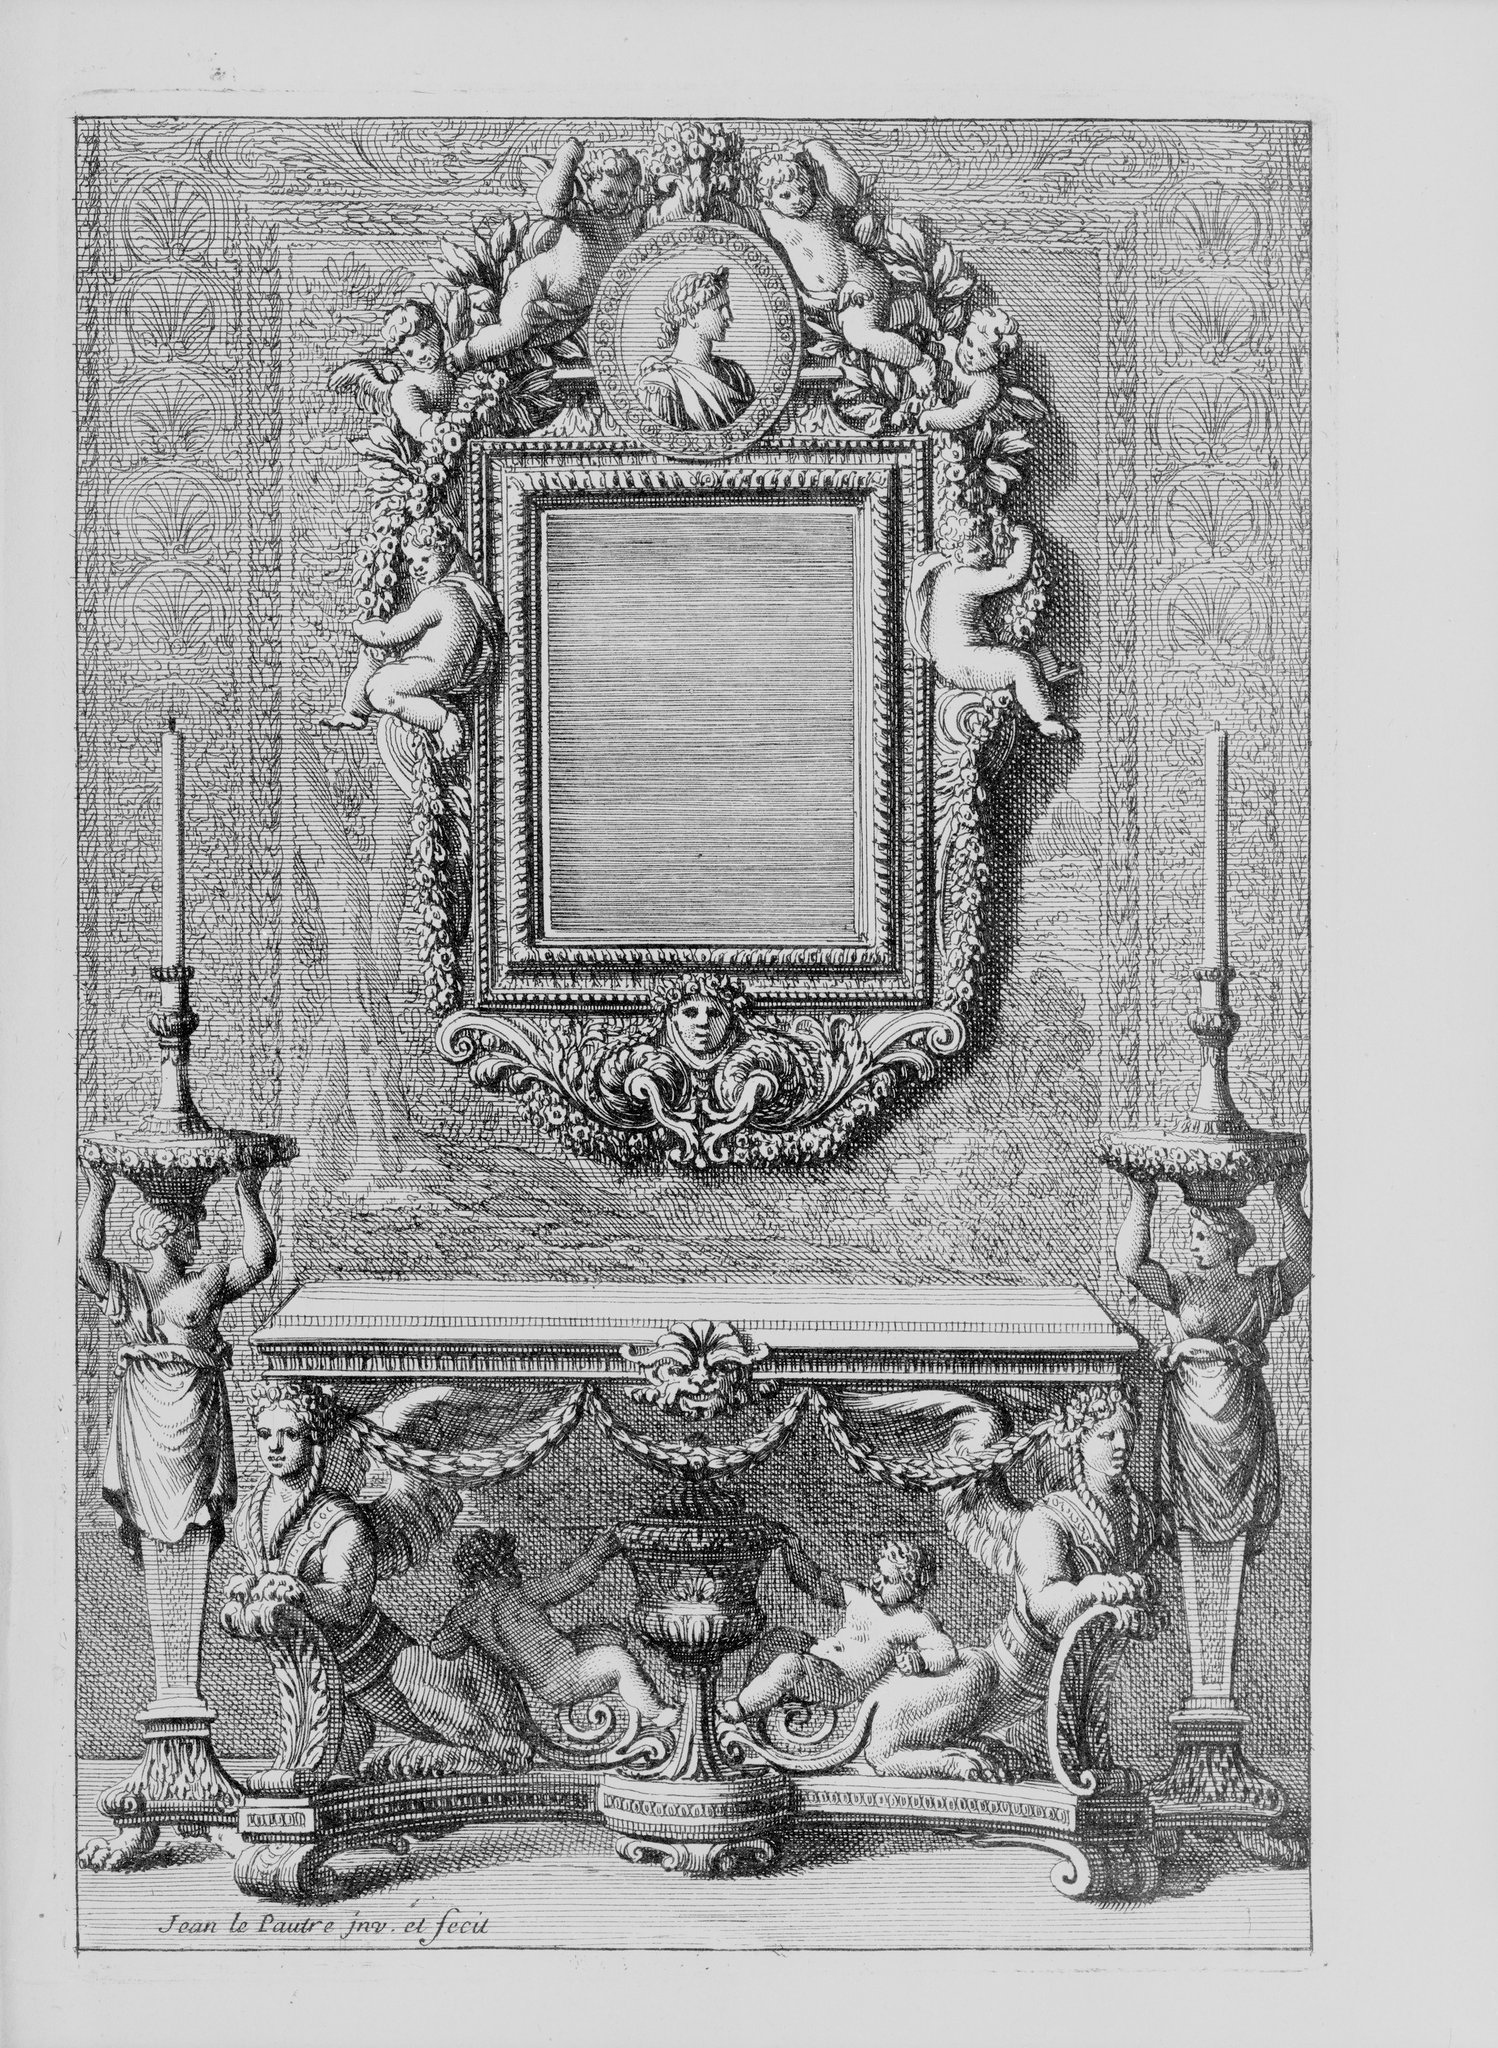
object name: book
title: Oeuvres, Vols. I-IV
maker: jean le pautre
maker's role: artist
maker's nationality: french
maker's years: 1618-1682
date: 1601-1700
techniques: engraving, etching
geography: france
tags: tables,mirrors